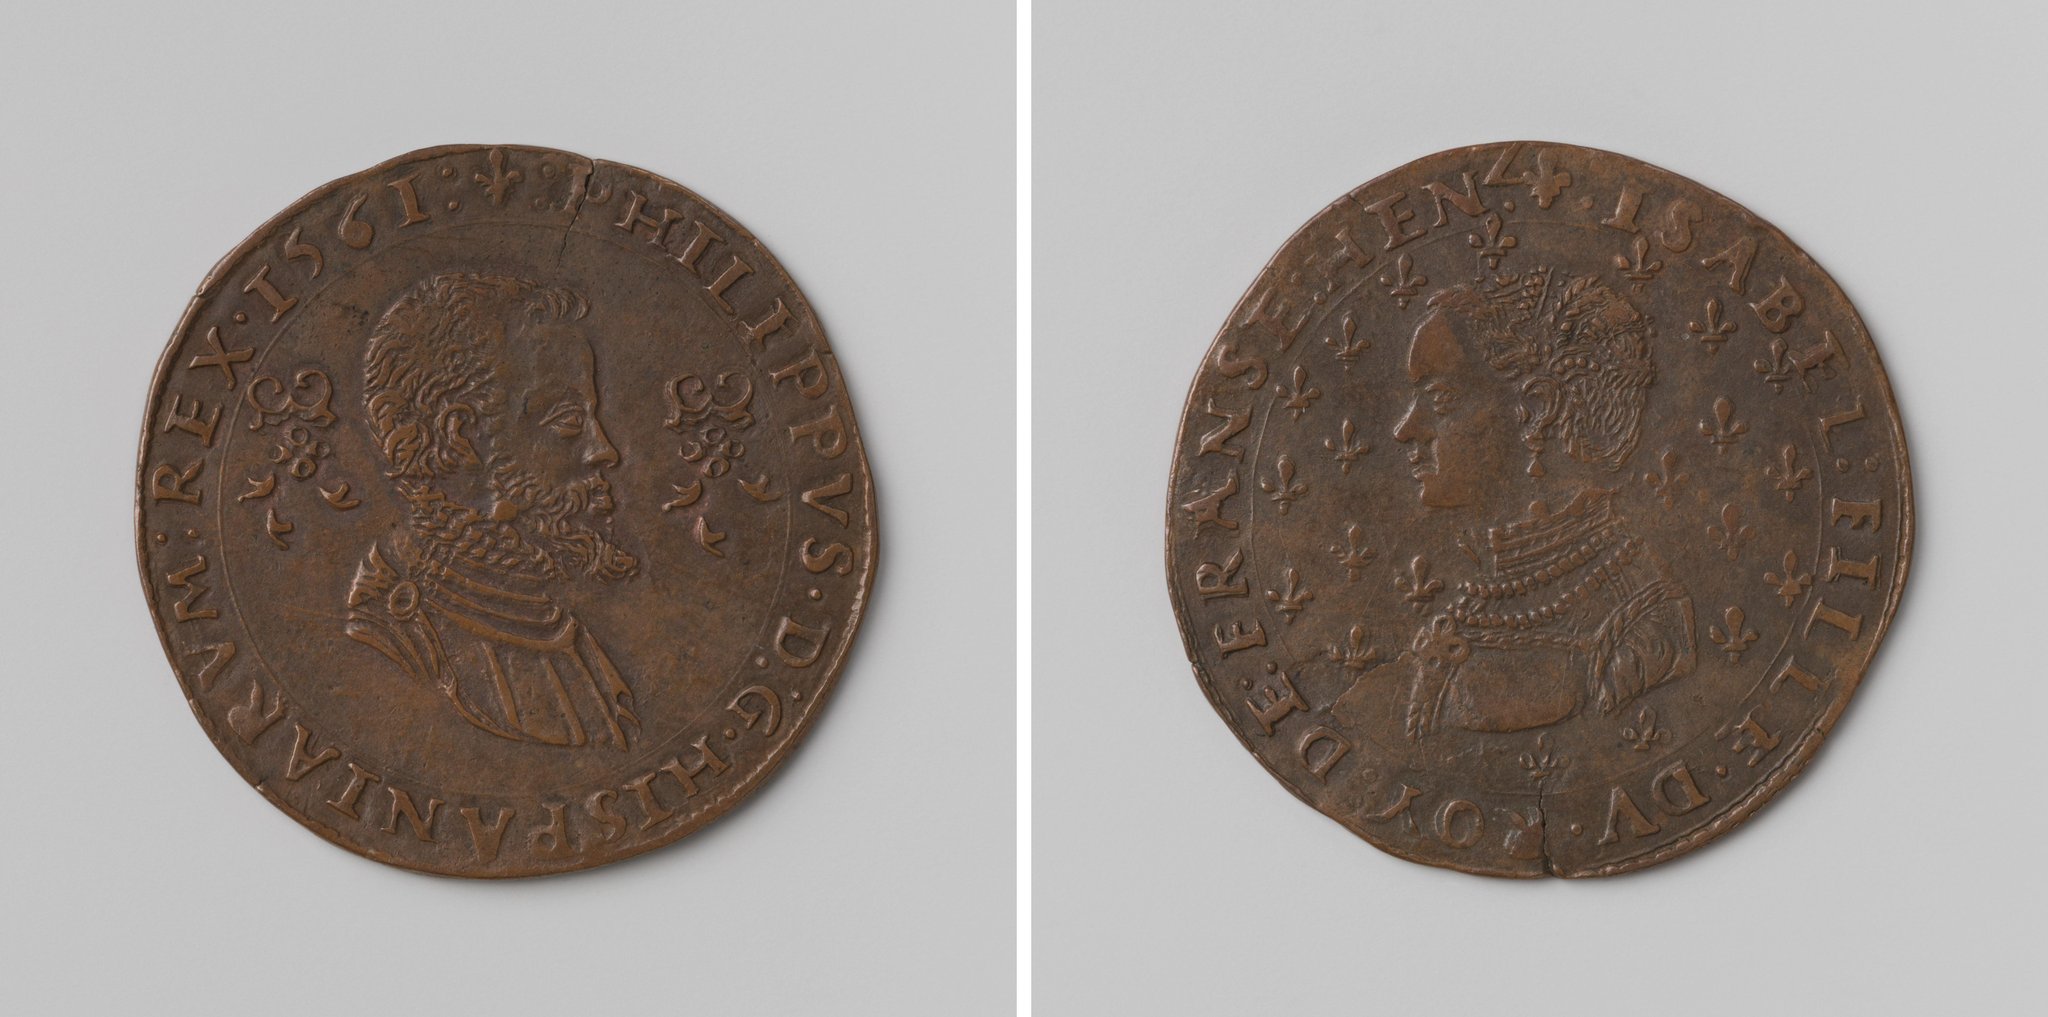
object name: jeton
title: Filips II en Isabella, koning en koningin van Spanje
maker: Anonymous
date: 1561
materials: copper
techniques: striking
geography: wallonia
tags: philip ii of spain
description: Koperen penning. Voorzijde: borststuk man tussen twee vuurslagen, waar vonken uitschieten binnen omschrift. Keerzijde: borststuk vrouw op veld, bezaaid met lelies binnen omschrift